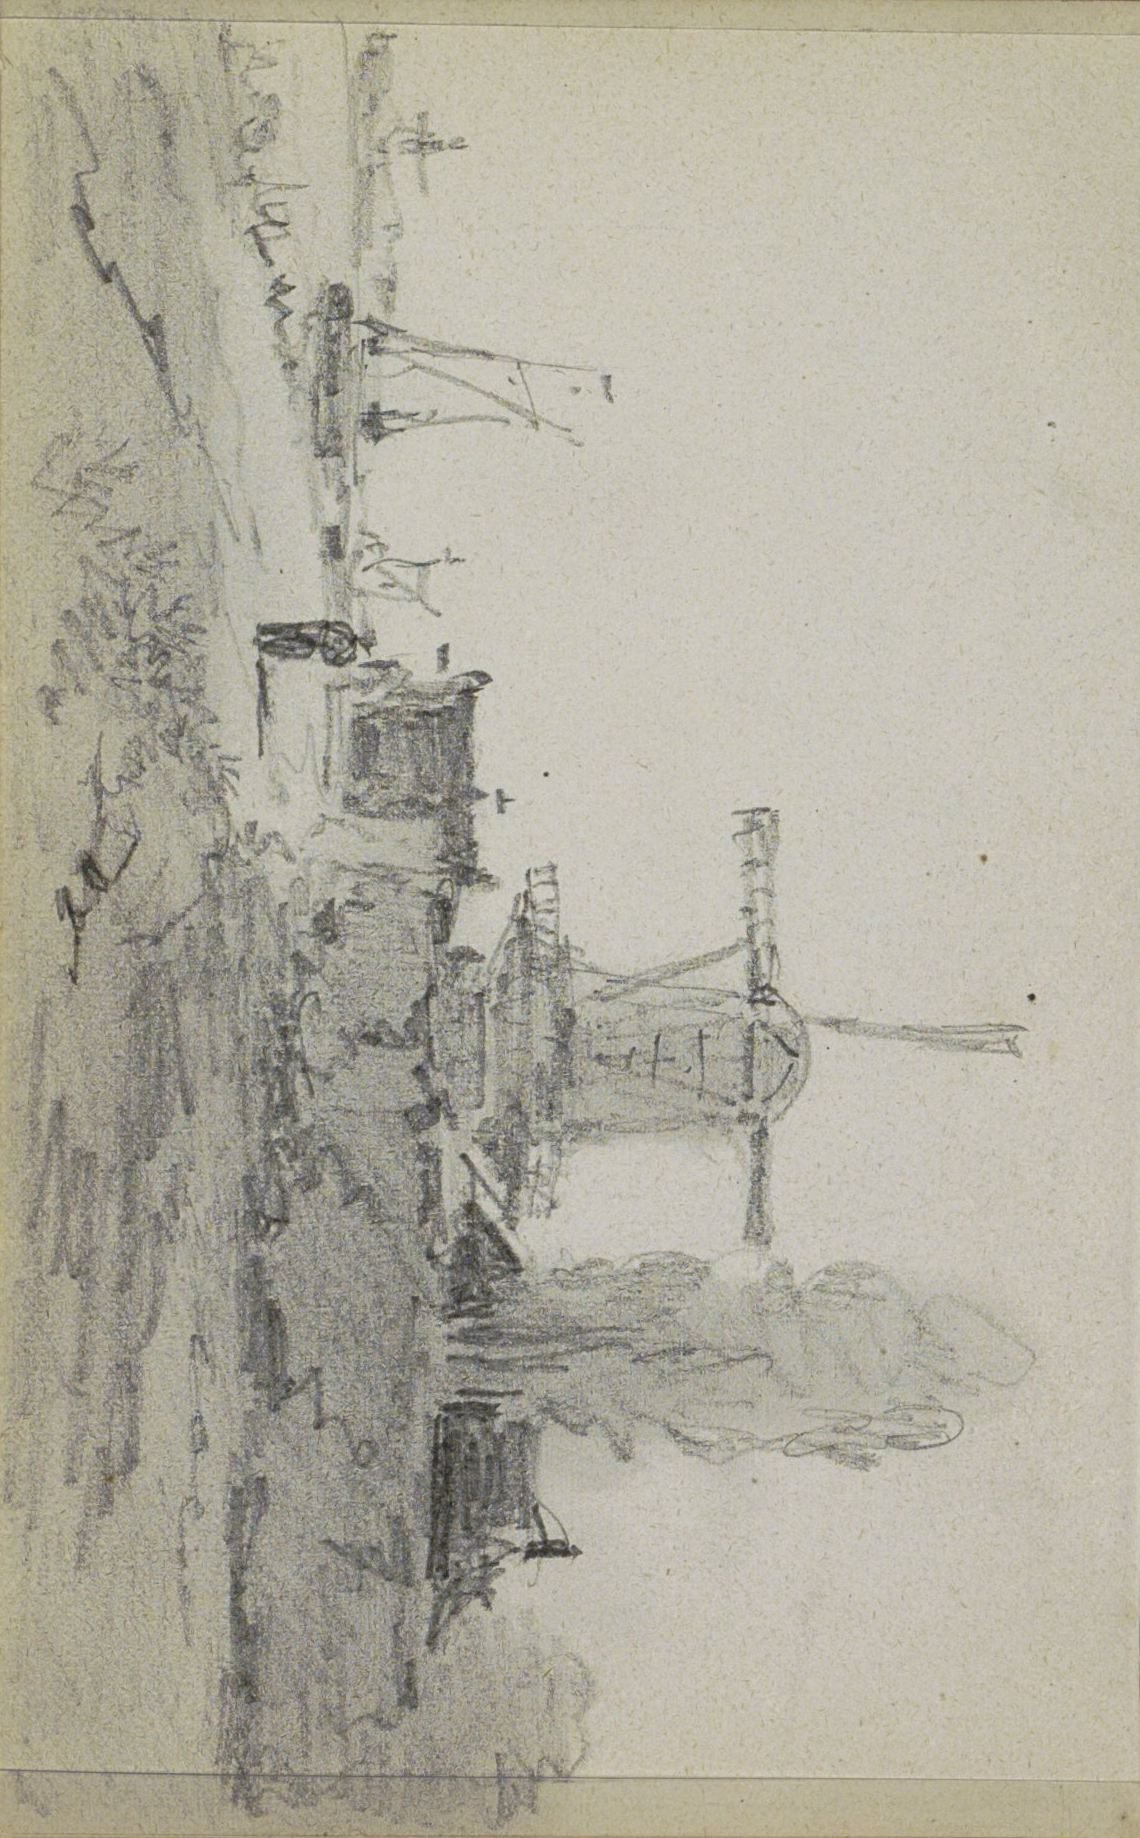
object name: sketchbook leaf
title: Gezicht op molens aan een rivier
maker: adrianus eversen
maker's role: draughtsman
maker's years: 1818-1897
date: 1828-1897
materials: paper, pencil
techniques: stumping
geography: netherlands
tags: sailing-ship, sailing-boat, river, windmill in landscape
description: Rechts een molen aan een rivier met zeilschepen. Op het pad een figuur. Links in de verte nog een molen. Blad 16 verso uit een schetsboek met 58 bladen.